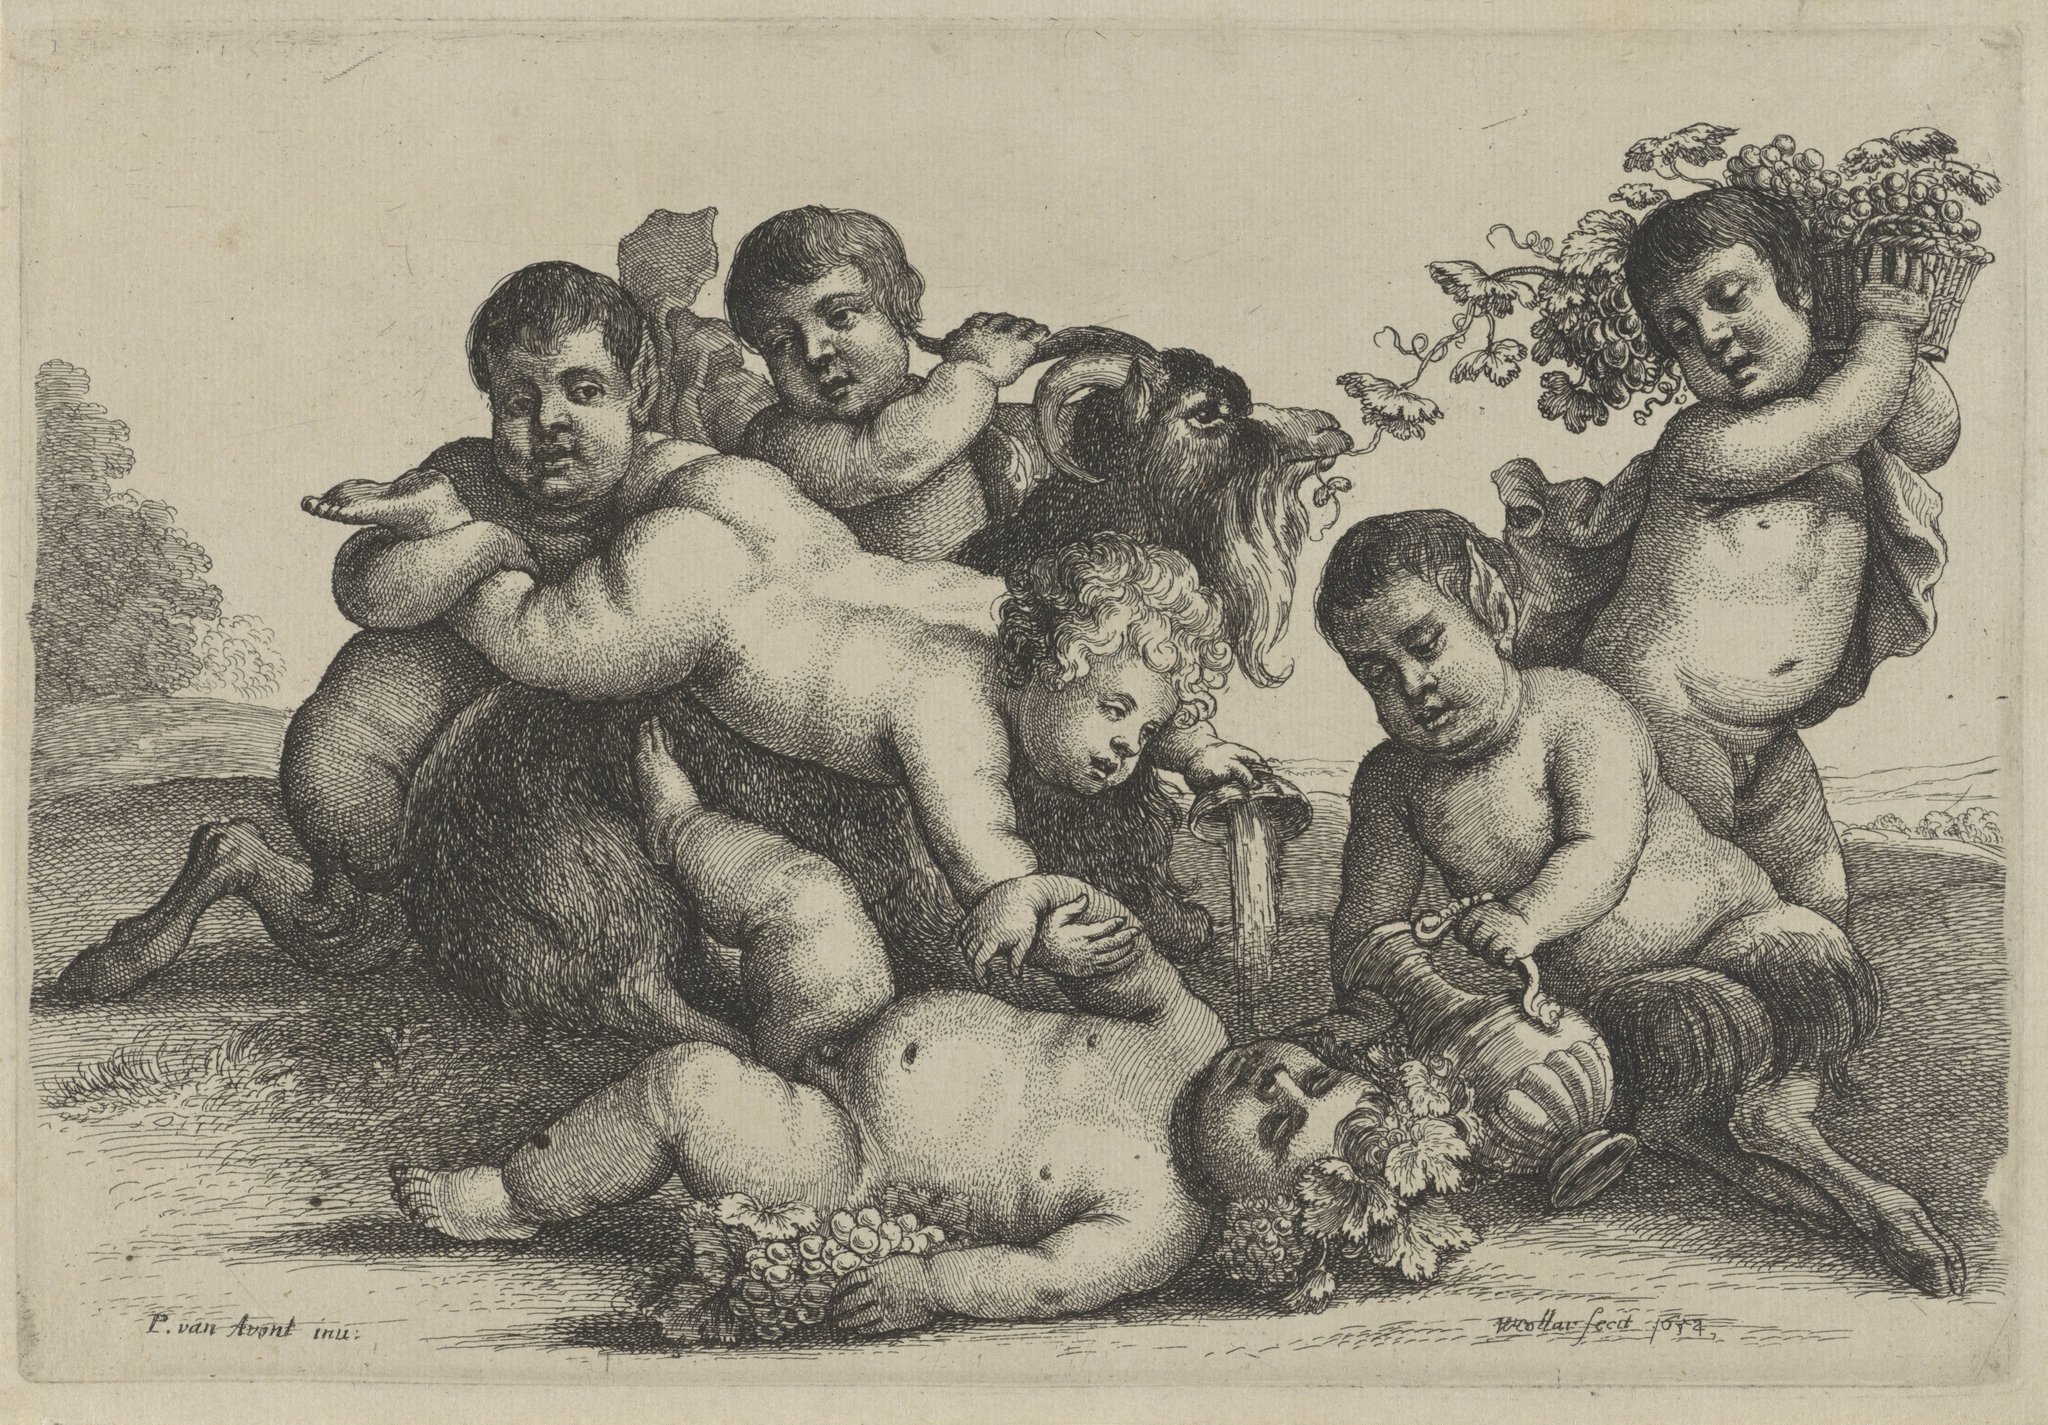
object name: print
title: Putti en saters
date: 1644-1652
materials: paper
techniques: etching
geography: antwerp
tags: boy (child between toddler and youth), male bacchant(es), satyr(s) (in general), goat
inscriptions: collector's mark: Lugt 2228